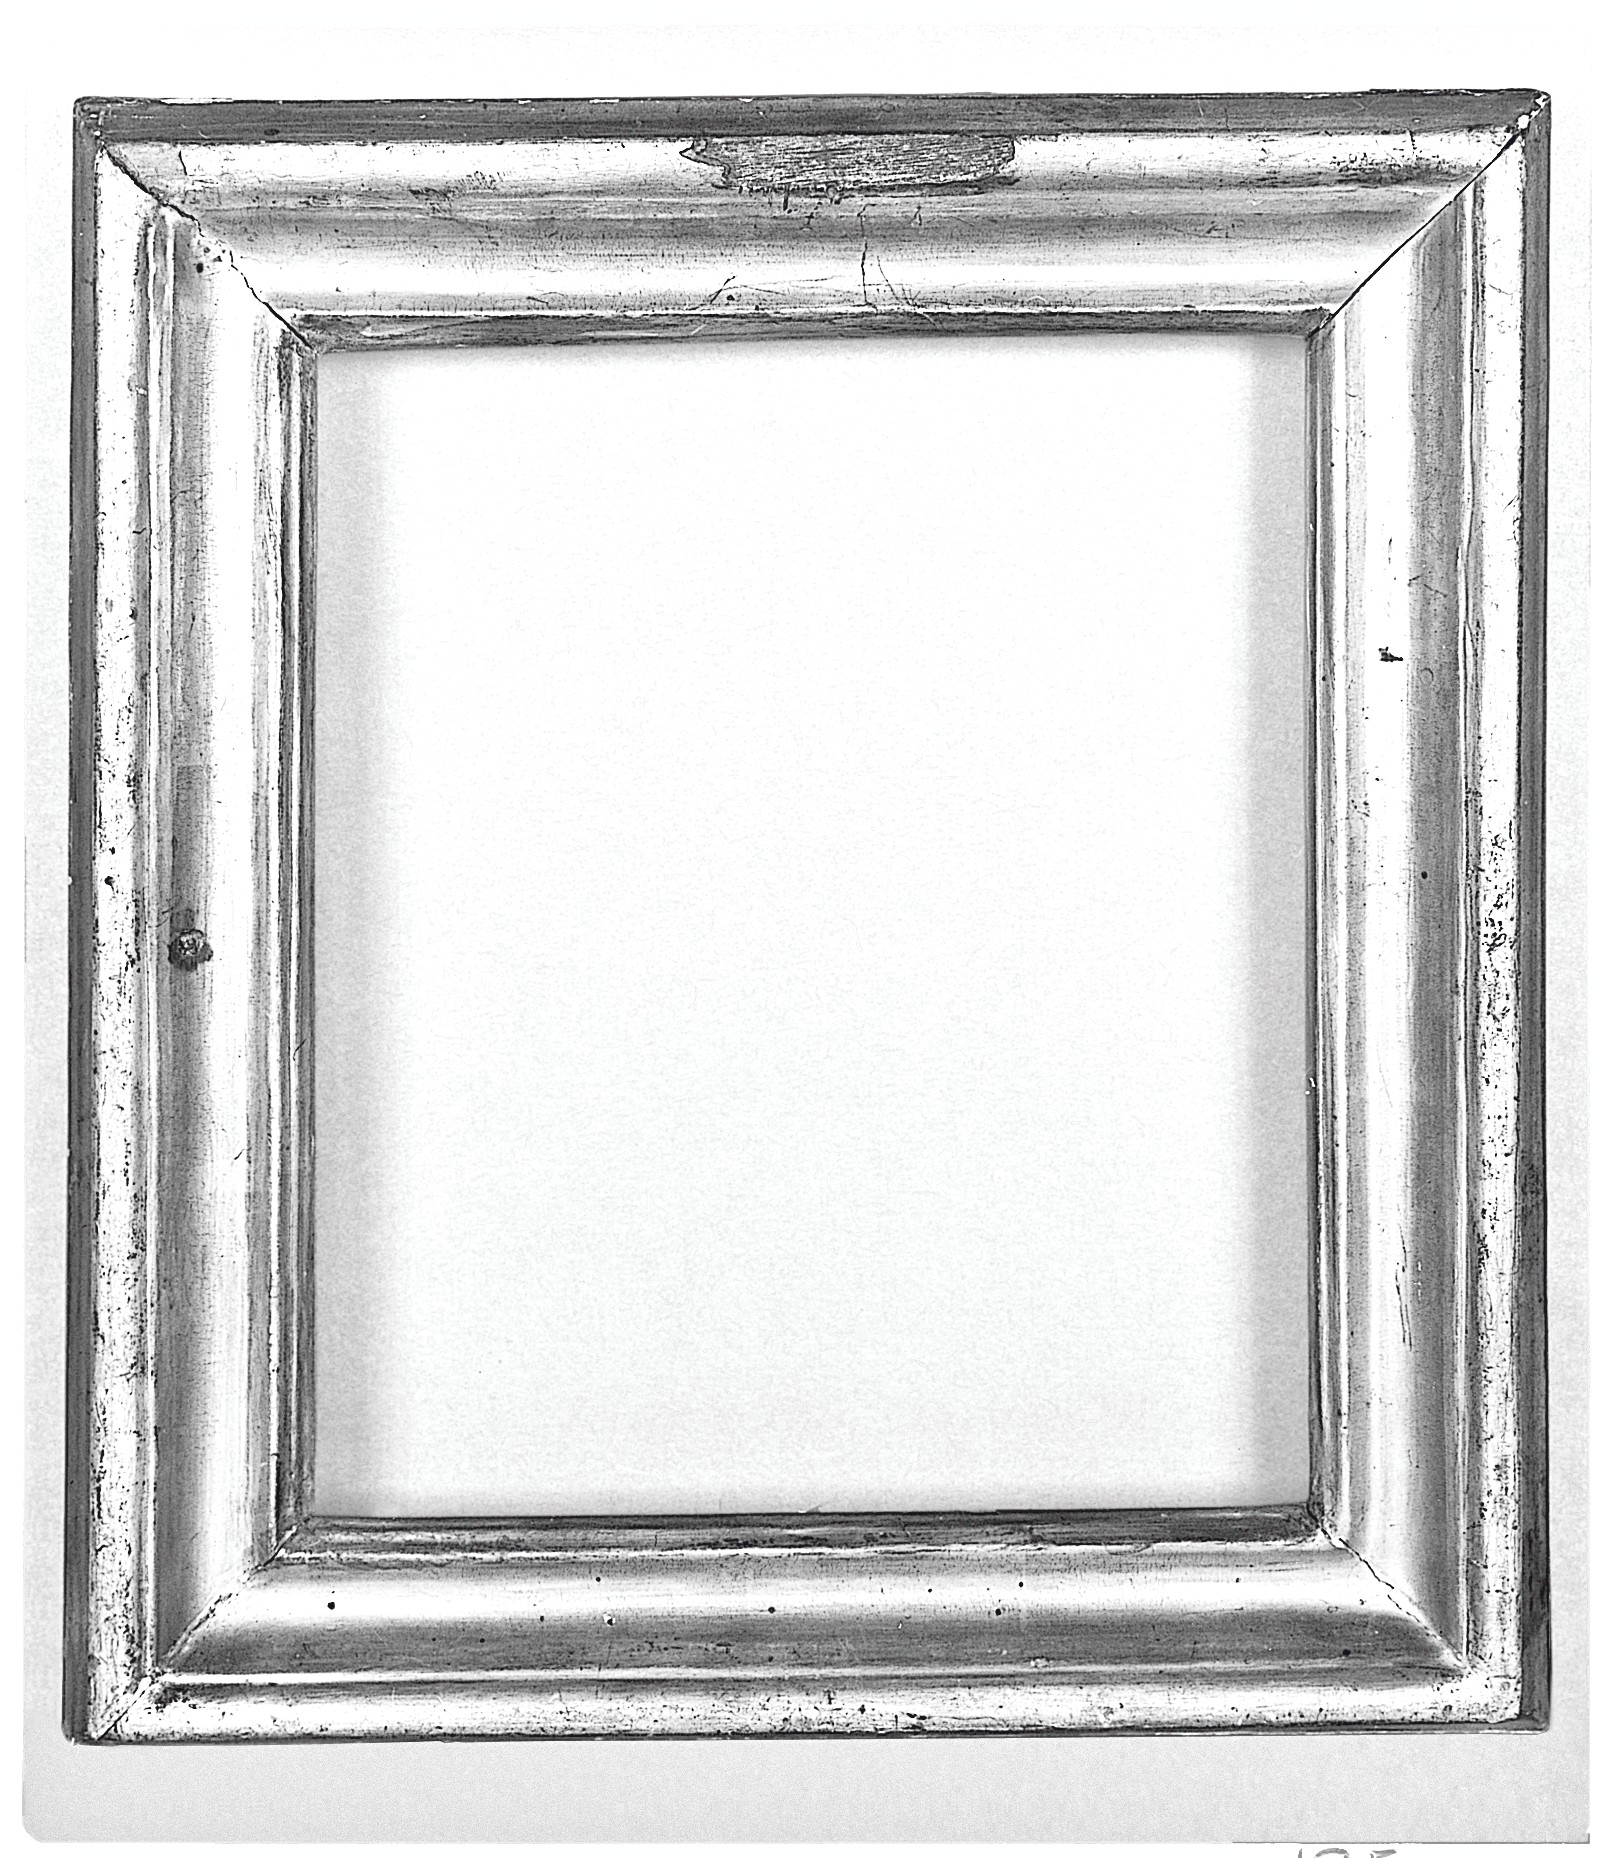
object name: frame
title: Salvator Rosa frame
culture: italian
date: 1770-1780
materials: wood